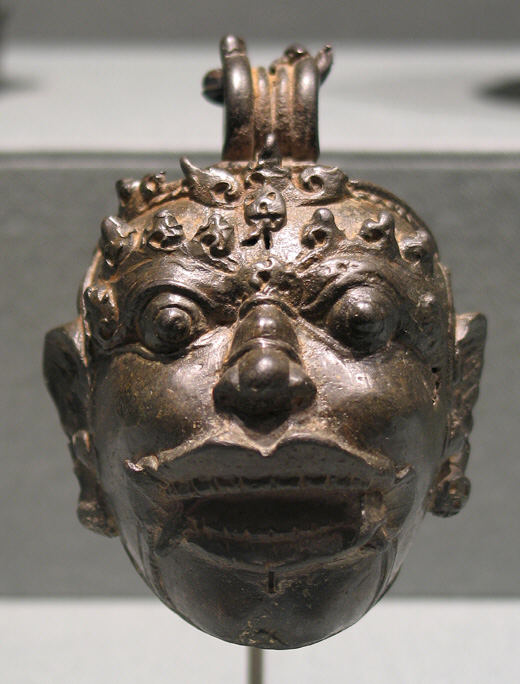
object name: bell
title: Pellet Bell in the Form of a Kala Head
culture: indonesian, javanese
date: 1101-1200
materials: bronze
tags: musical instruments,faces,heads